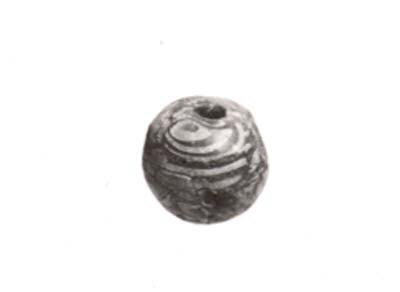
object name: bead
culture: sasanian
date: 201-700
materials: stone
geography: iran